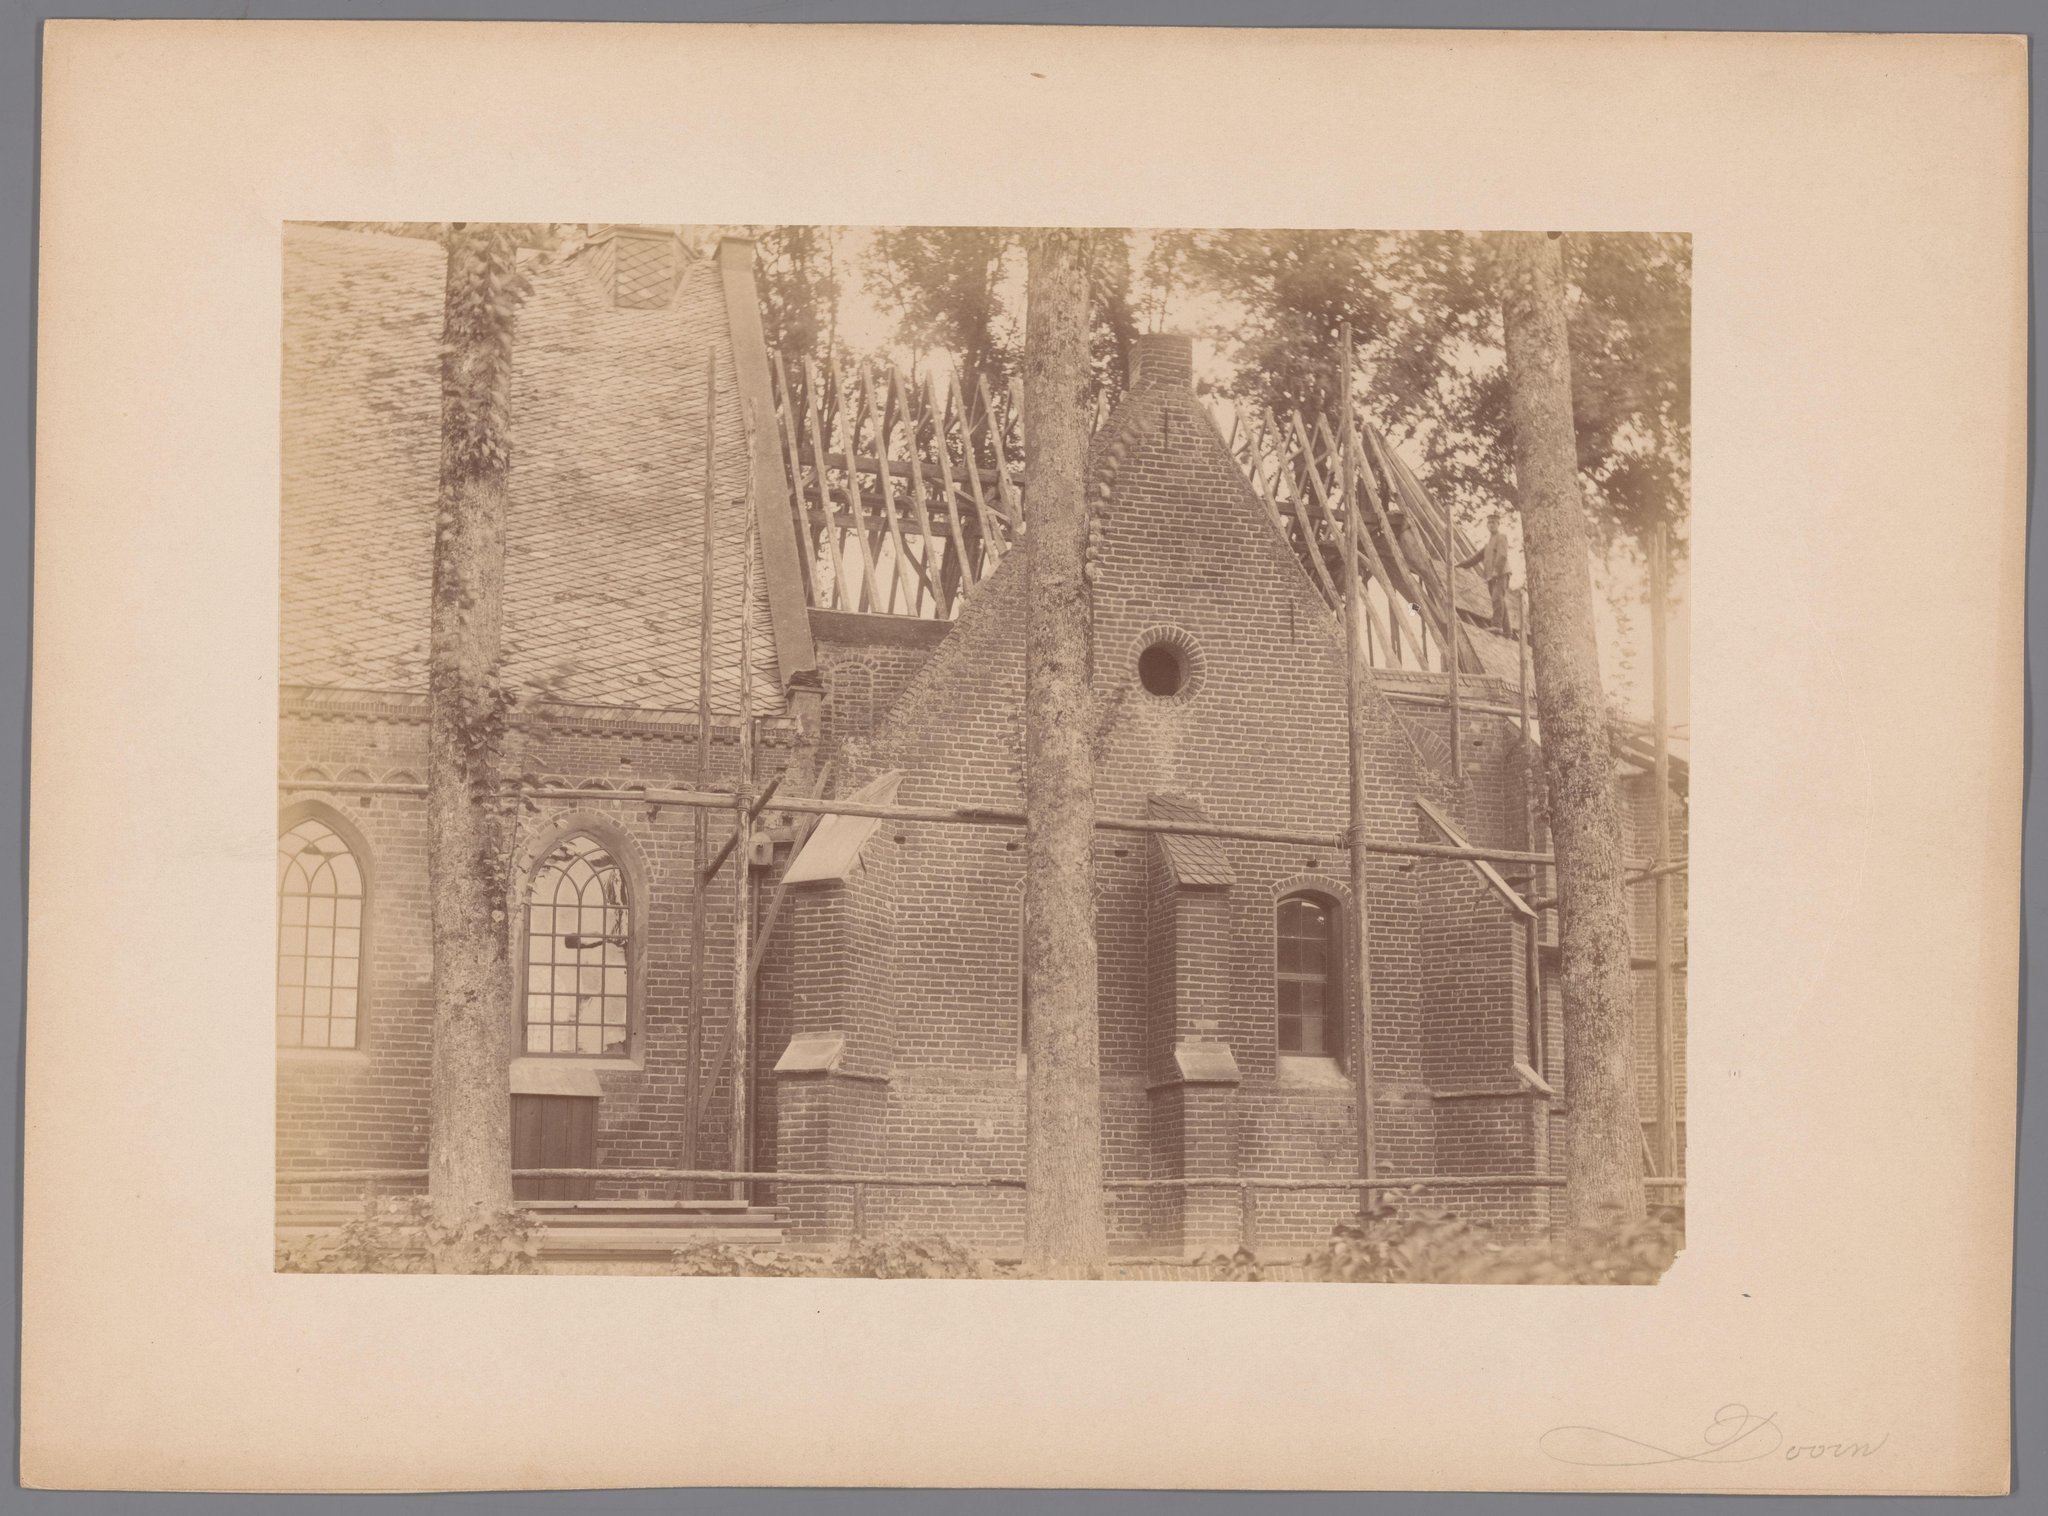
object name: photograph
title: Zuidzijde van de Maartenskerk te Doorn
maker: anoniem (monumentenzorg)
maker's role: fotograaf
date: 1890-1920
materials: cardboard, photographic support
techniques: albumen print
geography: doorn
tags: church (exterior)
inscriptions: annotation: ‘Doorn/ N.H. Kerk/ Zuidzijde’, annotation: ‘Doorn’